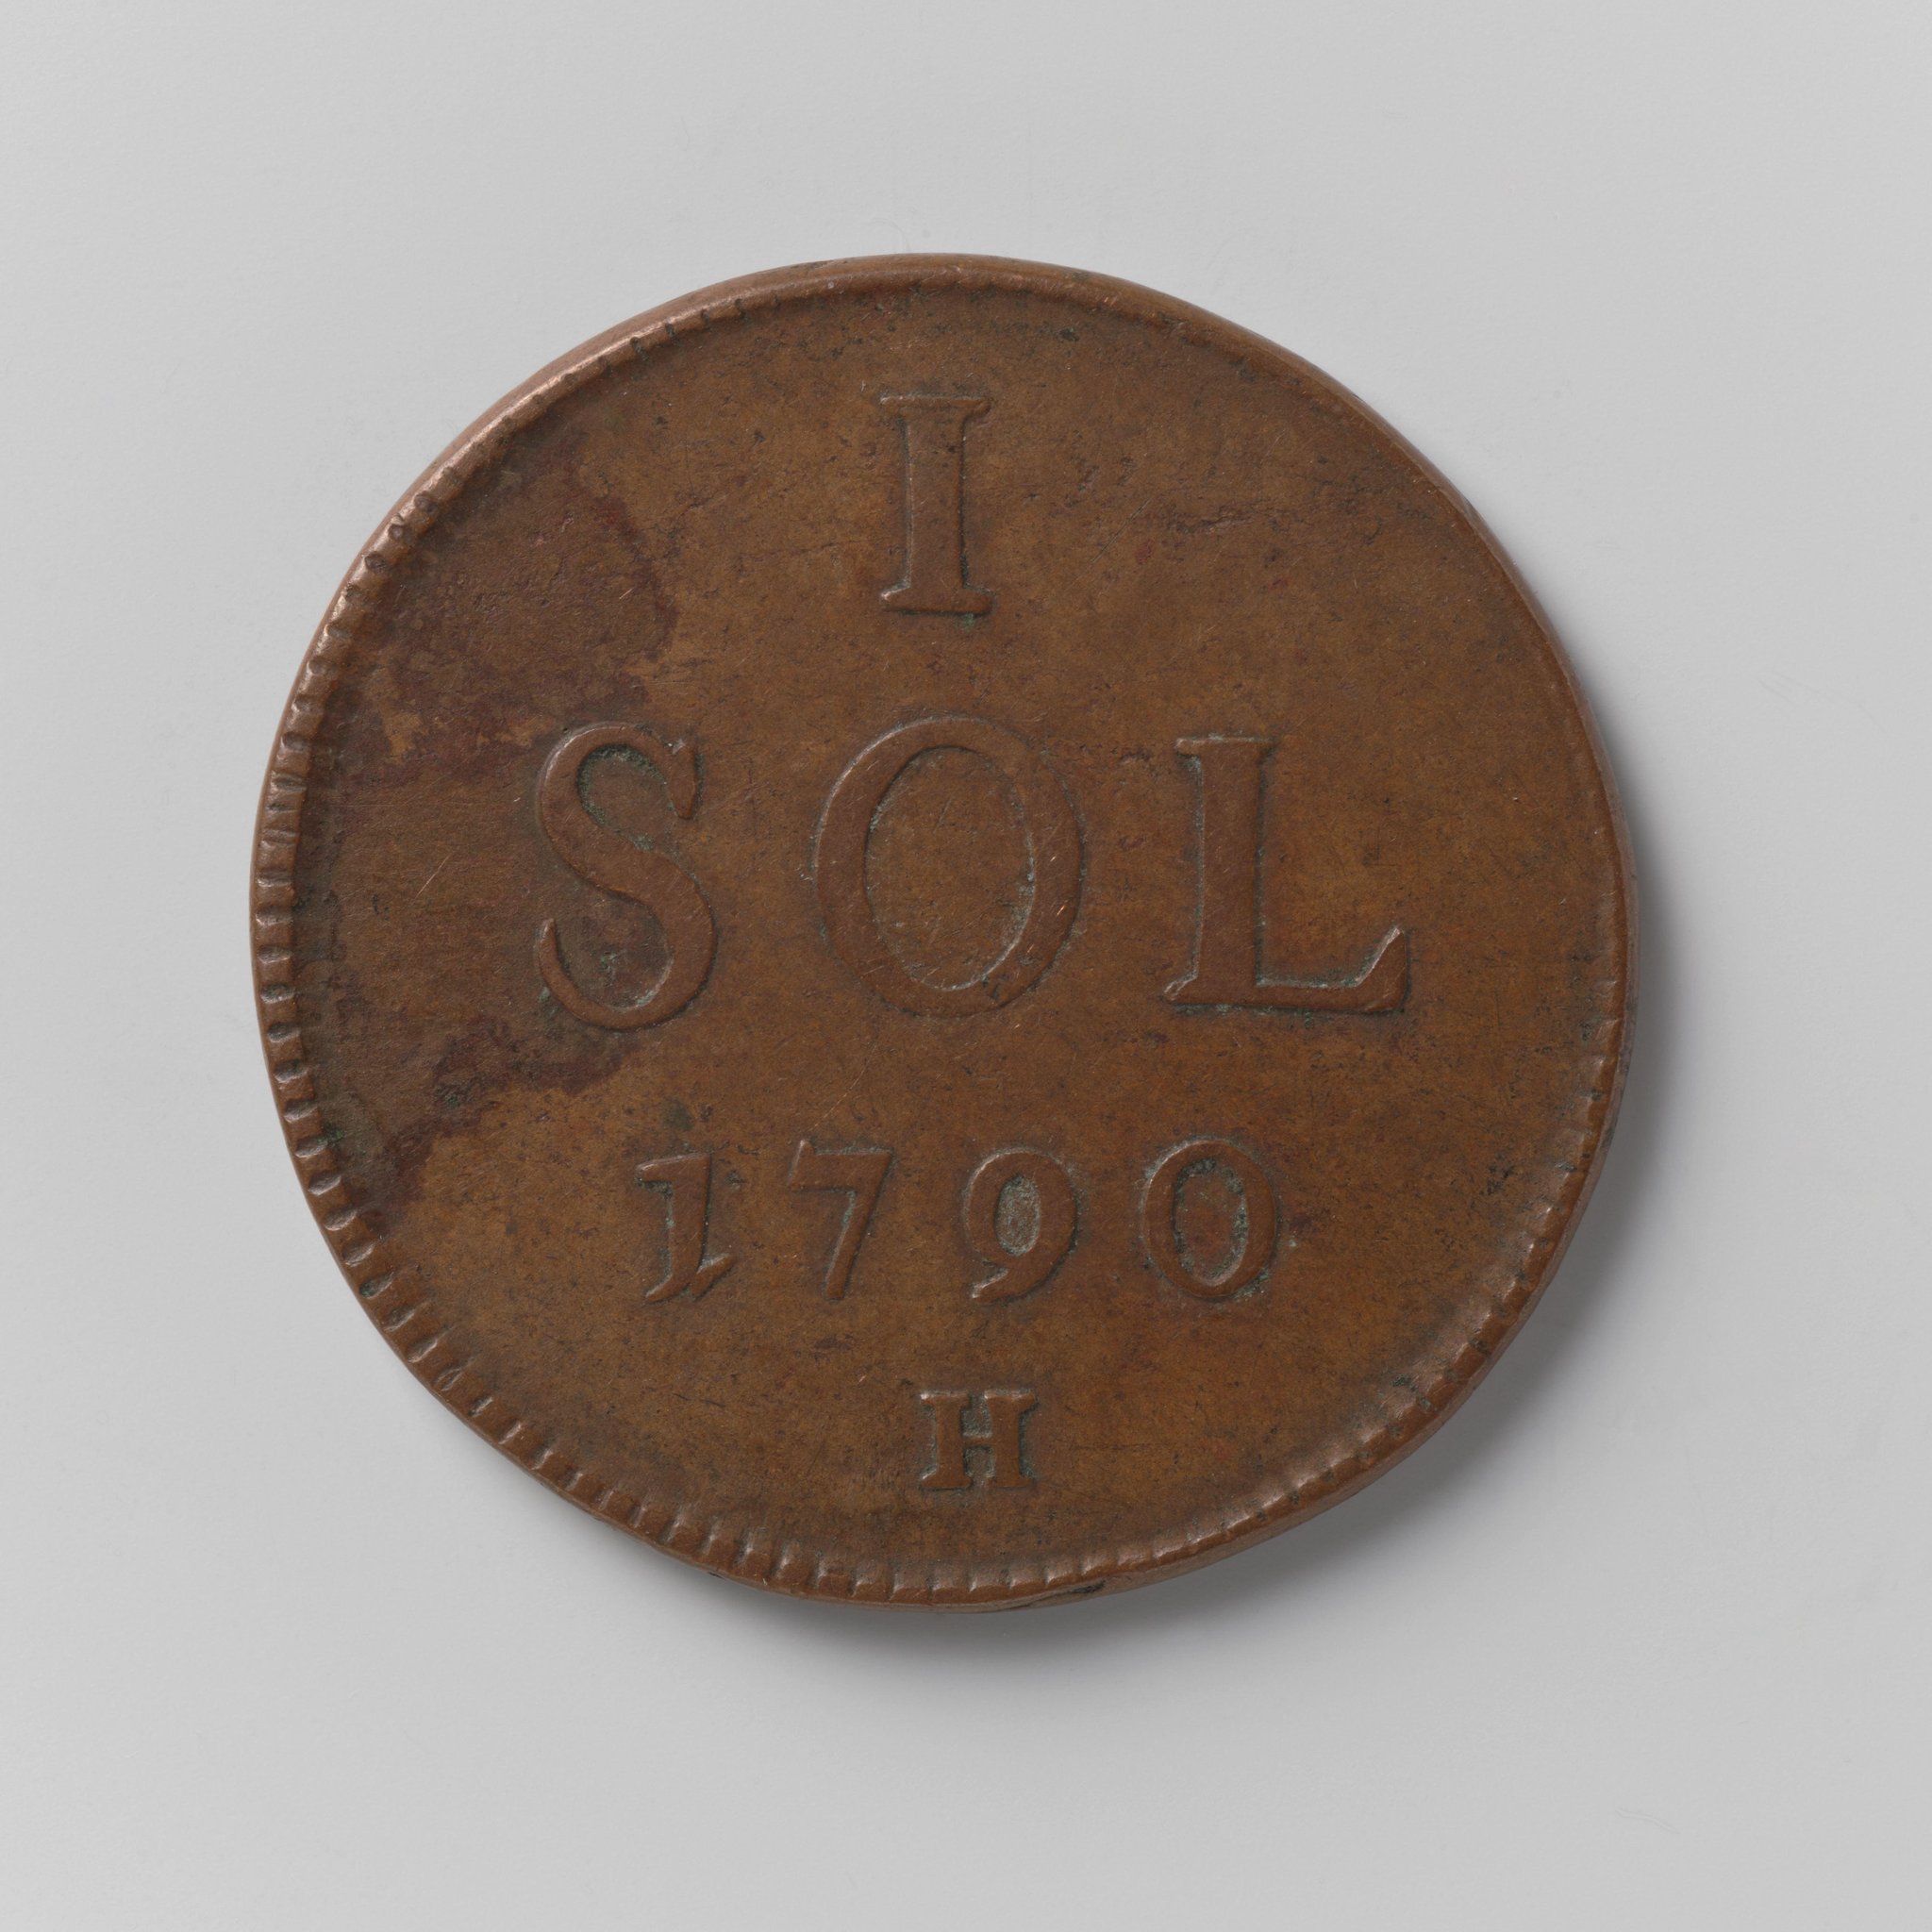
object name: coin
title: Luxemburg, Jozef II, sol of stuiver, 1790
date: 1790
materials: copper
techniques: striking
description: Koperen munt. Voorzijde: gekroond wapenschild. Keerzijde: in twee regels waarde-aanduiding, waaronder jaartal. Daaronder letter H van muntplaats Günzburg. Gladde rand.